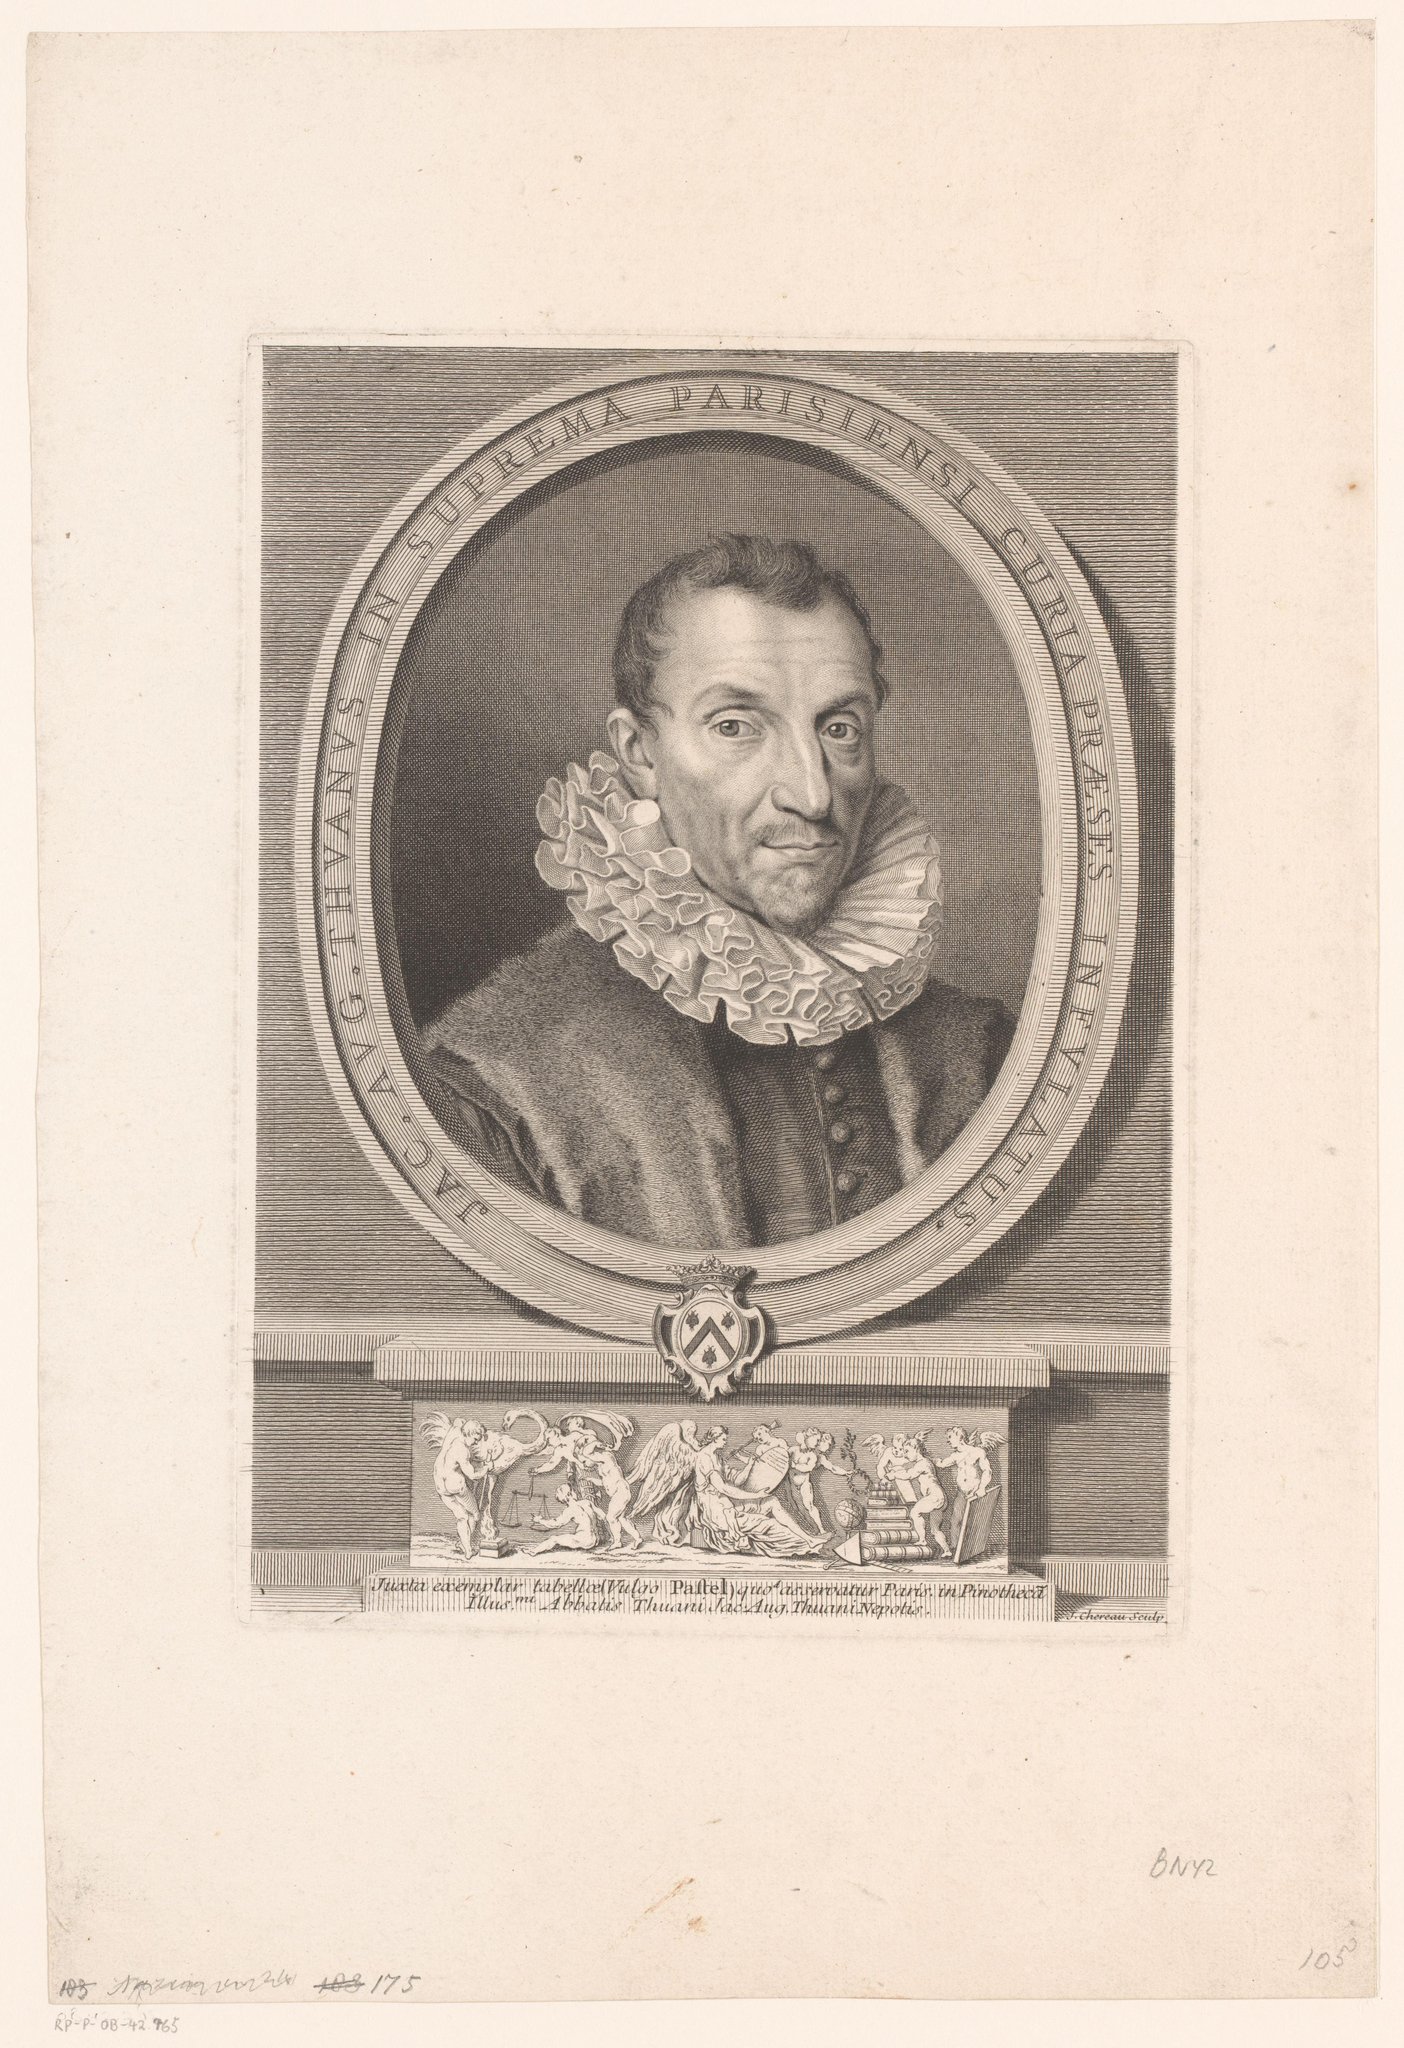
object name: print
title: Jac. Aug. Thuanus in suprema Parisiensi curia praeses infulatus.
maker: jacques chéreau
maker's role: print maker, publisher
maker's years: 1688-1776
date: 1698-1776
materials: paper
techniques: engraving, etching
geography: france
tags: politician, ornament ~ medallion, historical persons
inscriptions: collector's mark: Lugt 240